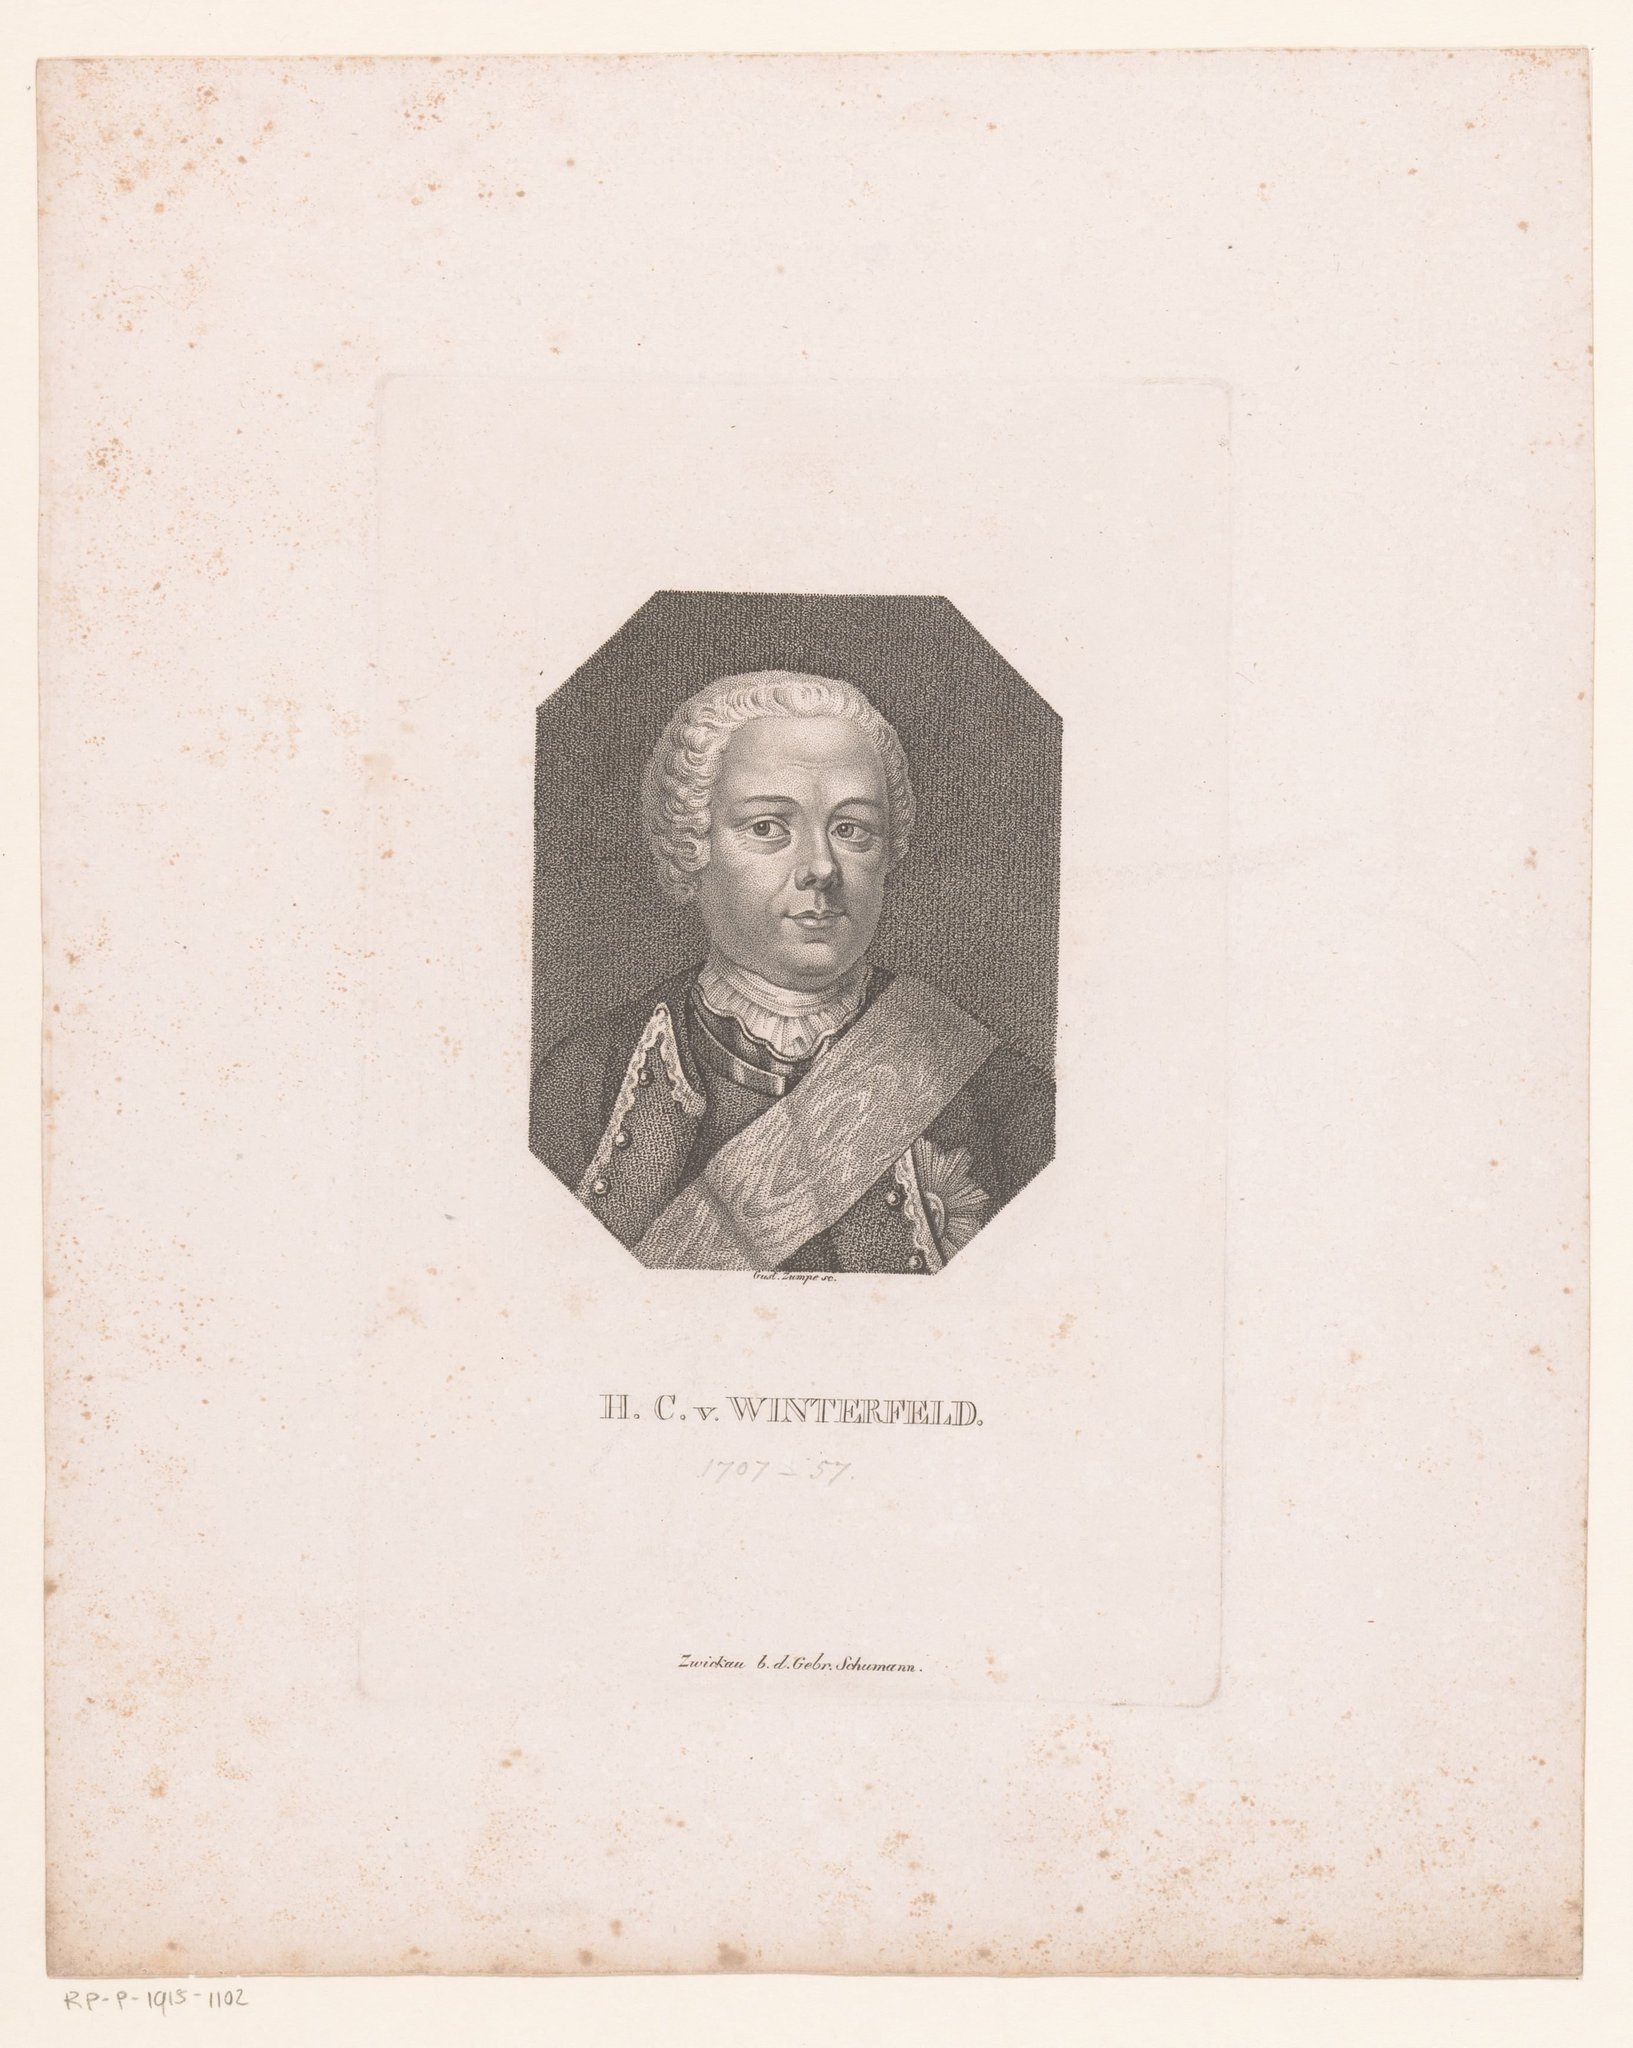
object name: print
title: Portretten van beroemde mensen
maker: gustav zumpe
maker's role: print maker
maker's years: 1793-1854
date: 1818-1832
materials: paper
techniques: engraving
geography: germany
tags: historical persons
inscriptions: collector's mark: Lugt 2228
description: Prent gebruikt door de serie 'Bildnisse der berühmtesten Menschen aller Völker und Zeiten', uitgegeven door de gebroeders Schumann in 1818-1832 te Zwickau.